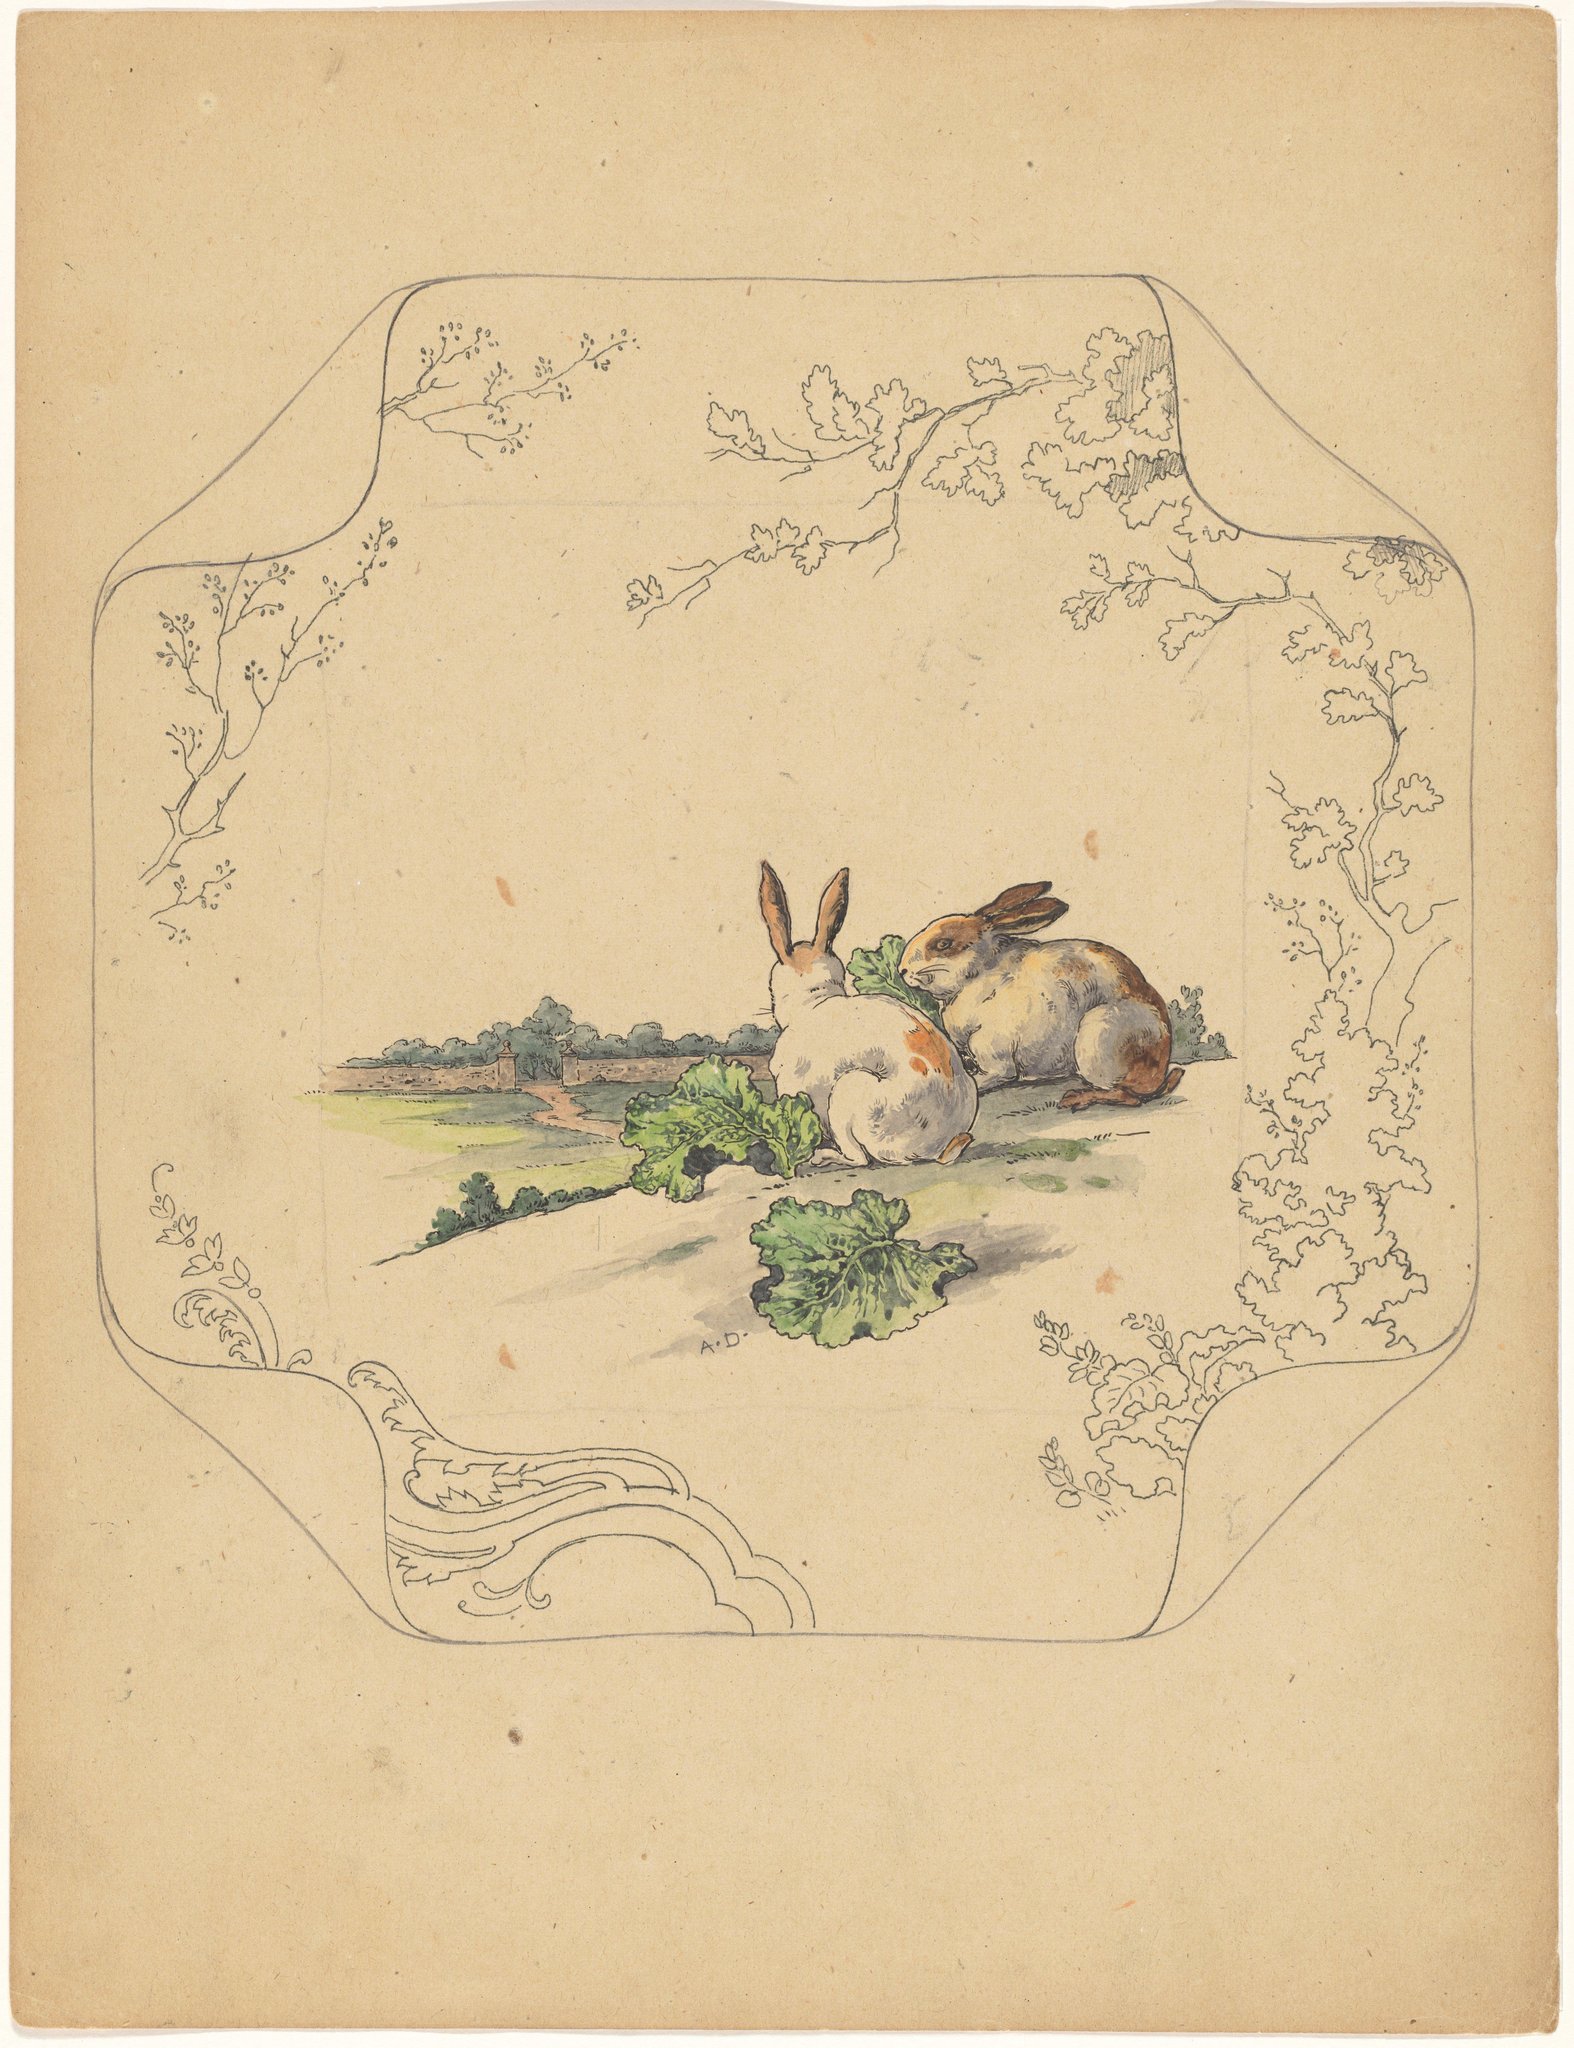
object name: drawing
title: Negen ontwerpen voor borden van het model 'Square' door Albert Dammouse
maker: albert louis dammouse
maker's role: ceramicist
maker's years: 1848-1926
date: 1875-1880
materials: graphite, ink, paper, watercolor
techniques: brush, pen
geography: sèvres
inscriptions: monogram: ‘A.D.’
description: Het plat gedecoreerd met twee konijnen met een ommuurde tuin op de achtergrond.